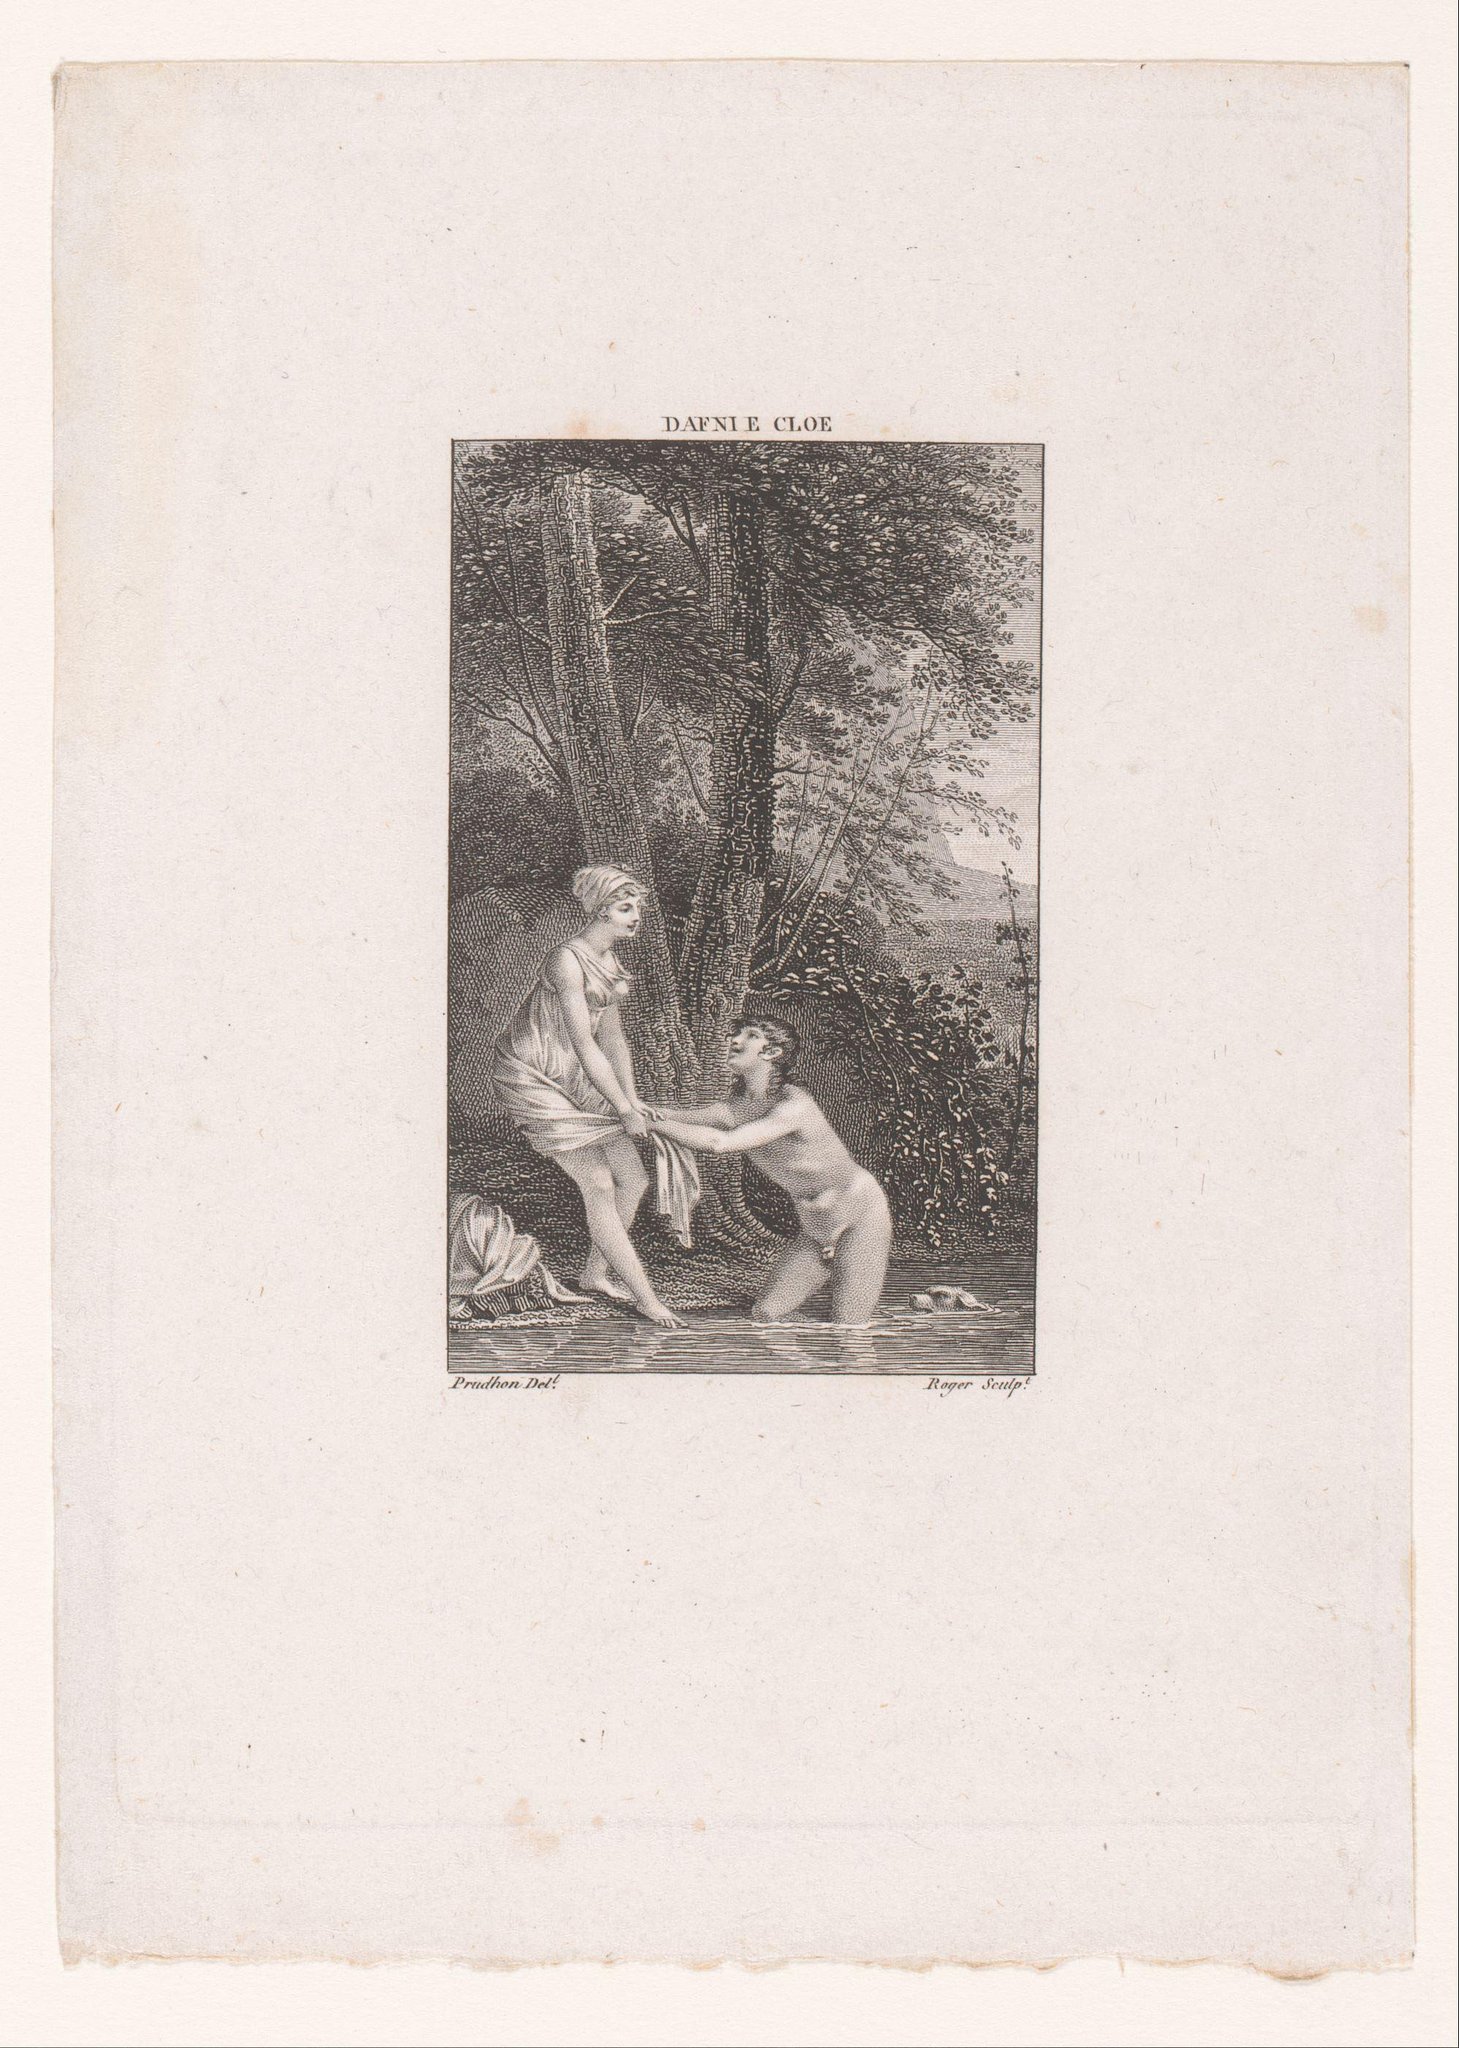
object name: print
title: Daphnis en Chloë badend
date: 1800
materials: paper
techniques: etching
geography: paris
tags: daphnis (in greek mythology a shepherd who invented pastoral poetry, chloe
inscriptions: collector's mark: Lugt 2228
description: Prent uit: Sofista, Longus. Gli amori pastorali di Dafni e Cloe. Parijs: Antoine Augustin Renouard, 1800.